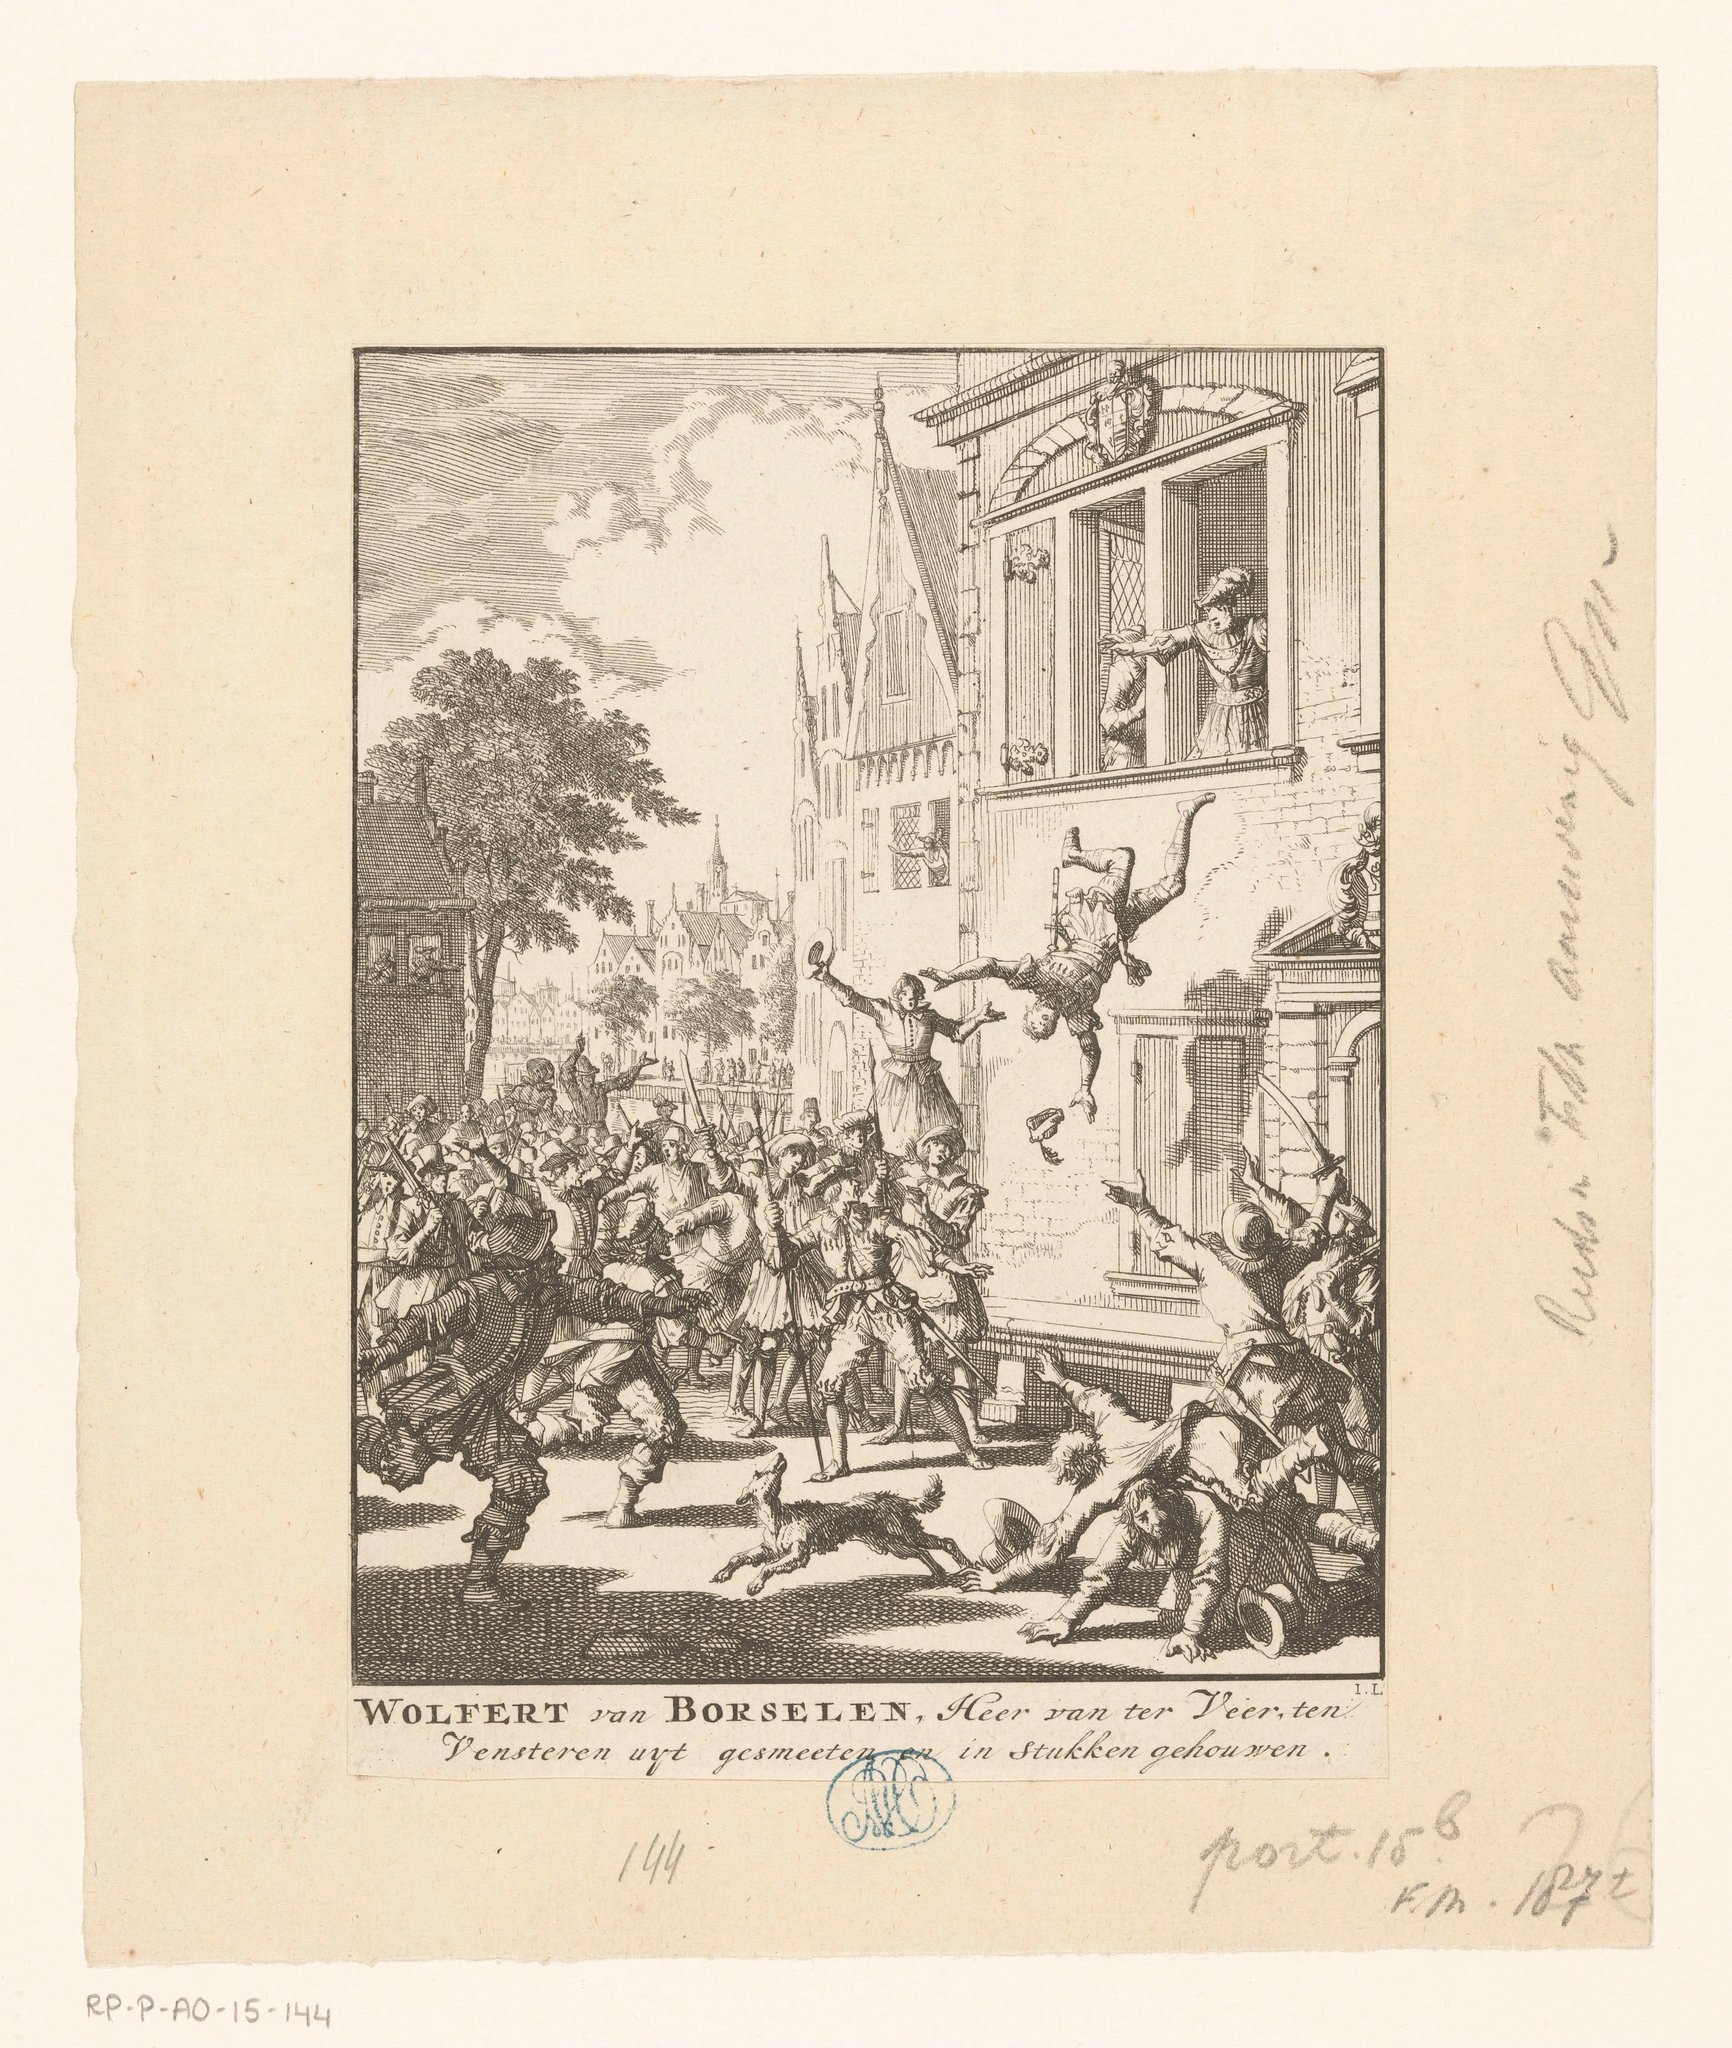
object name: print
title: Wolfert van Borselen te Delft uit het venster geworpen en vermoord, 1299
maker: jan luyken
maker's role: draughtsman, print maker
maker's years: 1649-1712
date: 1698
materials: paper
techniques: engraving, etching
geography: amsterdam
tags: lynching, delft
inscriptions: collector's mark: Lugt 195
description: Eerste bekende staat van prent ook gebruikt in: Bosch, Lambert van den. Treur-toonneel der doorluchtige mannen, of op- en ondergang der grooten, vertoont in de rampzalige geschiedenissen van (…). 3 delen. Amsterdam: Jan Claesz ten Hoorn, 1698, dl. 1, afd. 2, tussen p. 200 en 201. Omdat dit object binnen de plaatrand is afgesneden, is niet vast te stellen om welke staat het gaat.